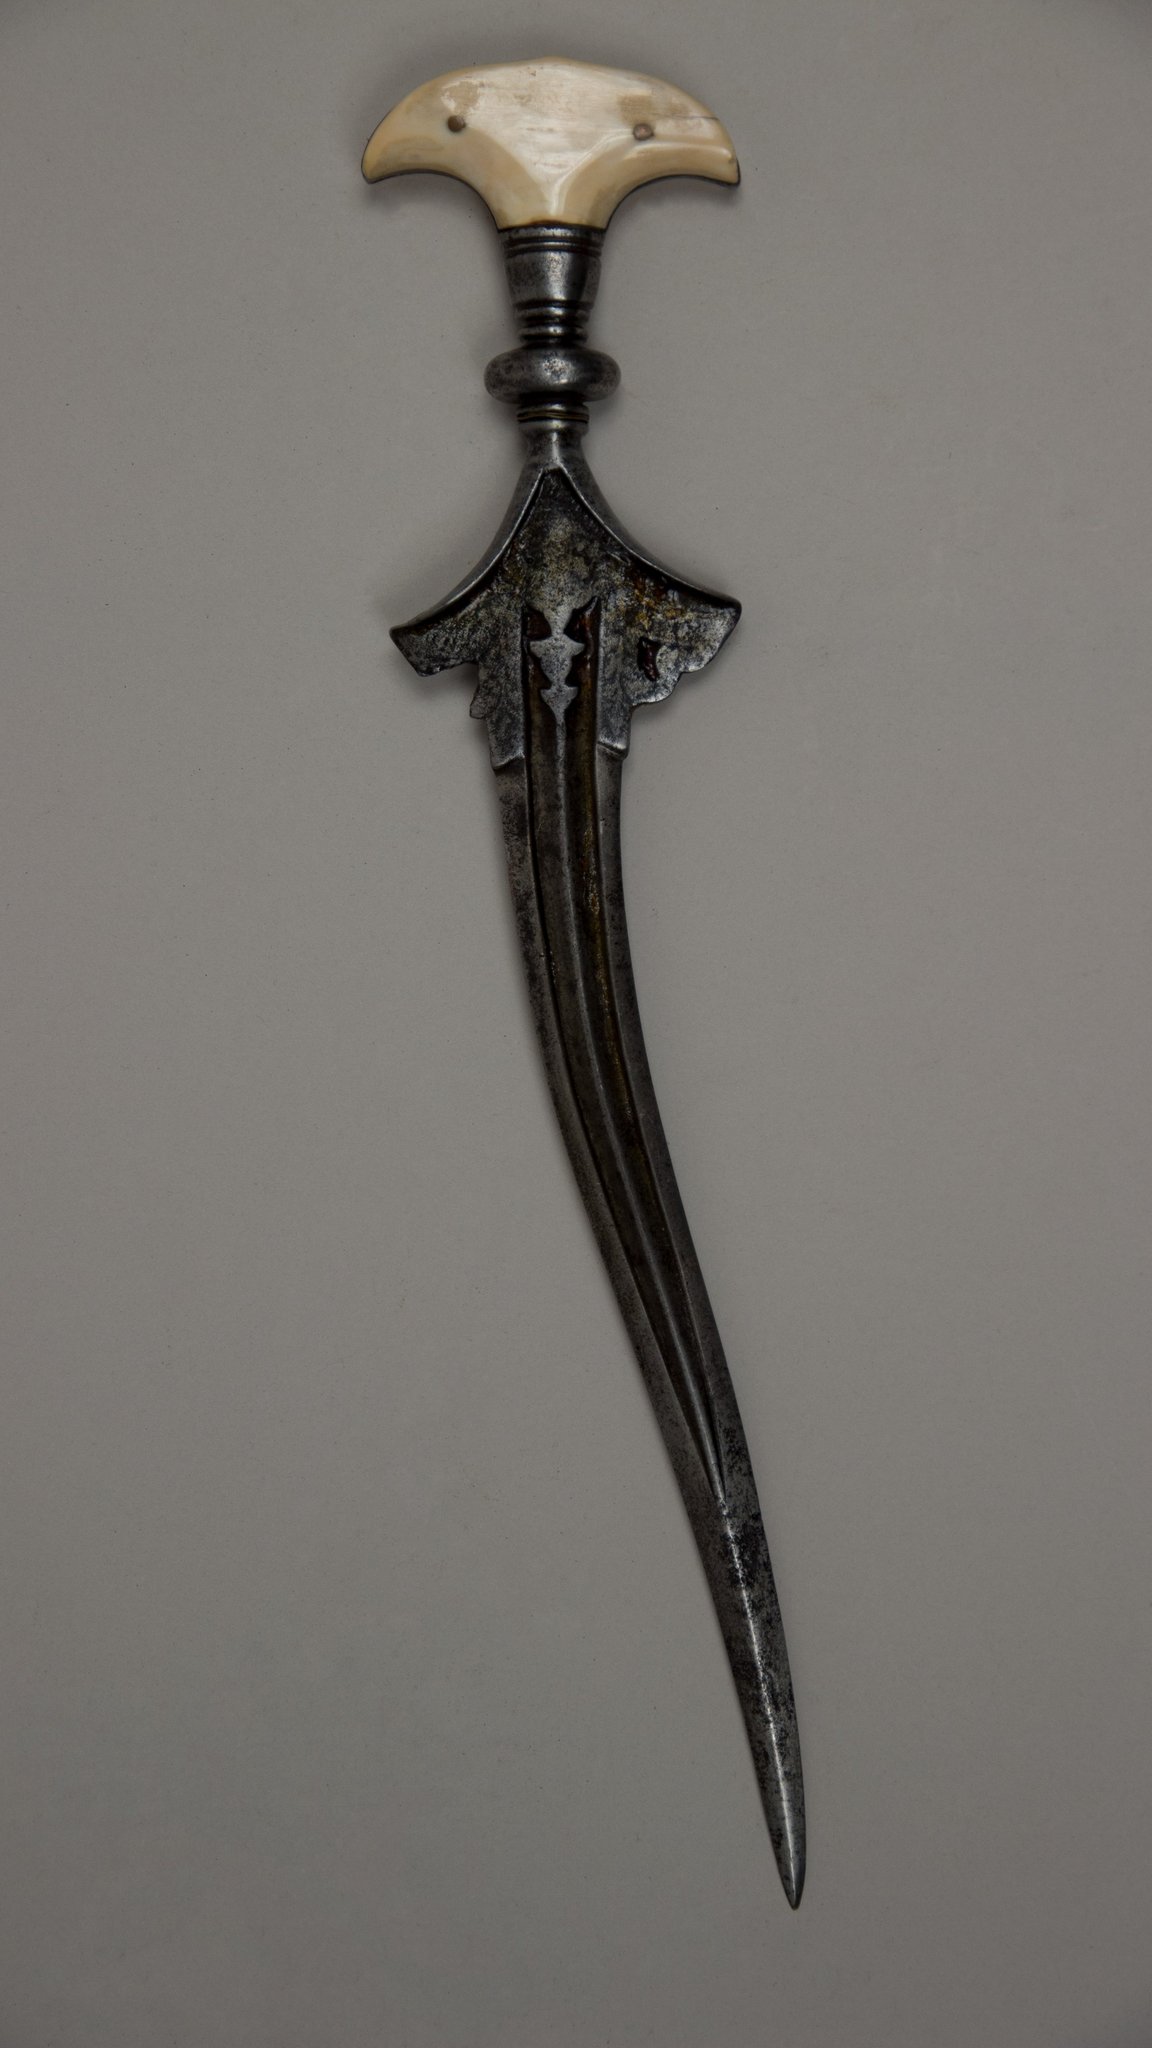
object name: dagger chilanum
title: Dagger (Chilanum)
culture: indian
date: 1601-1800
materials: ivory, steel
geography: india